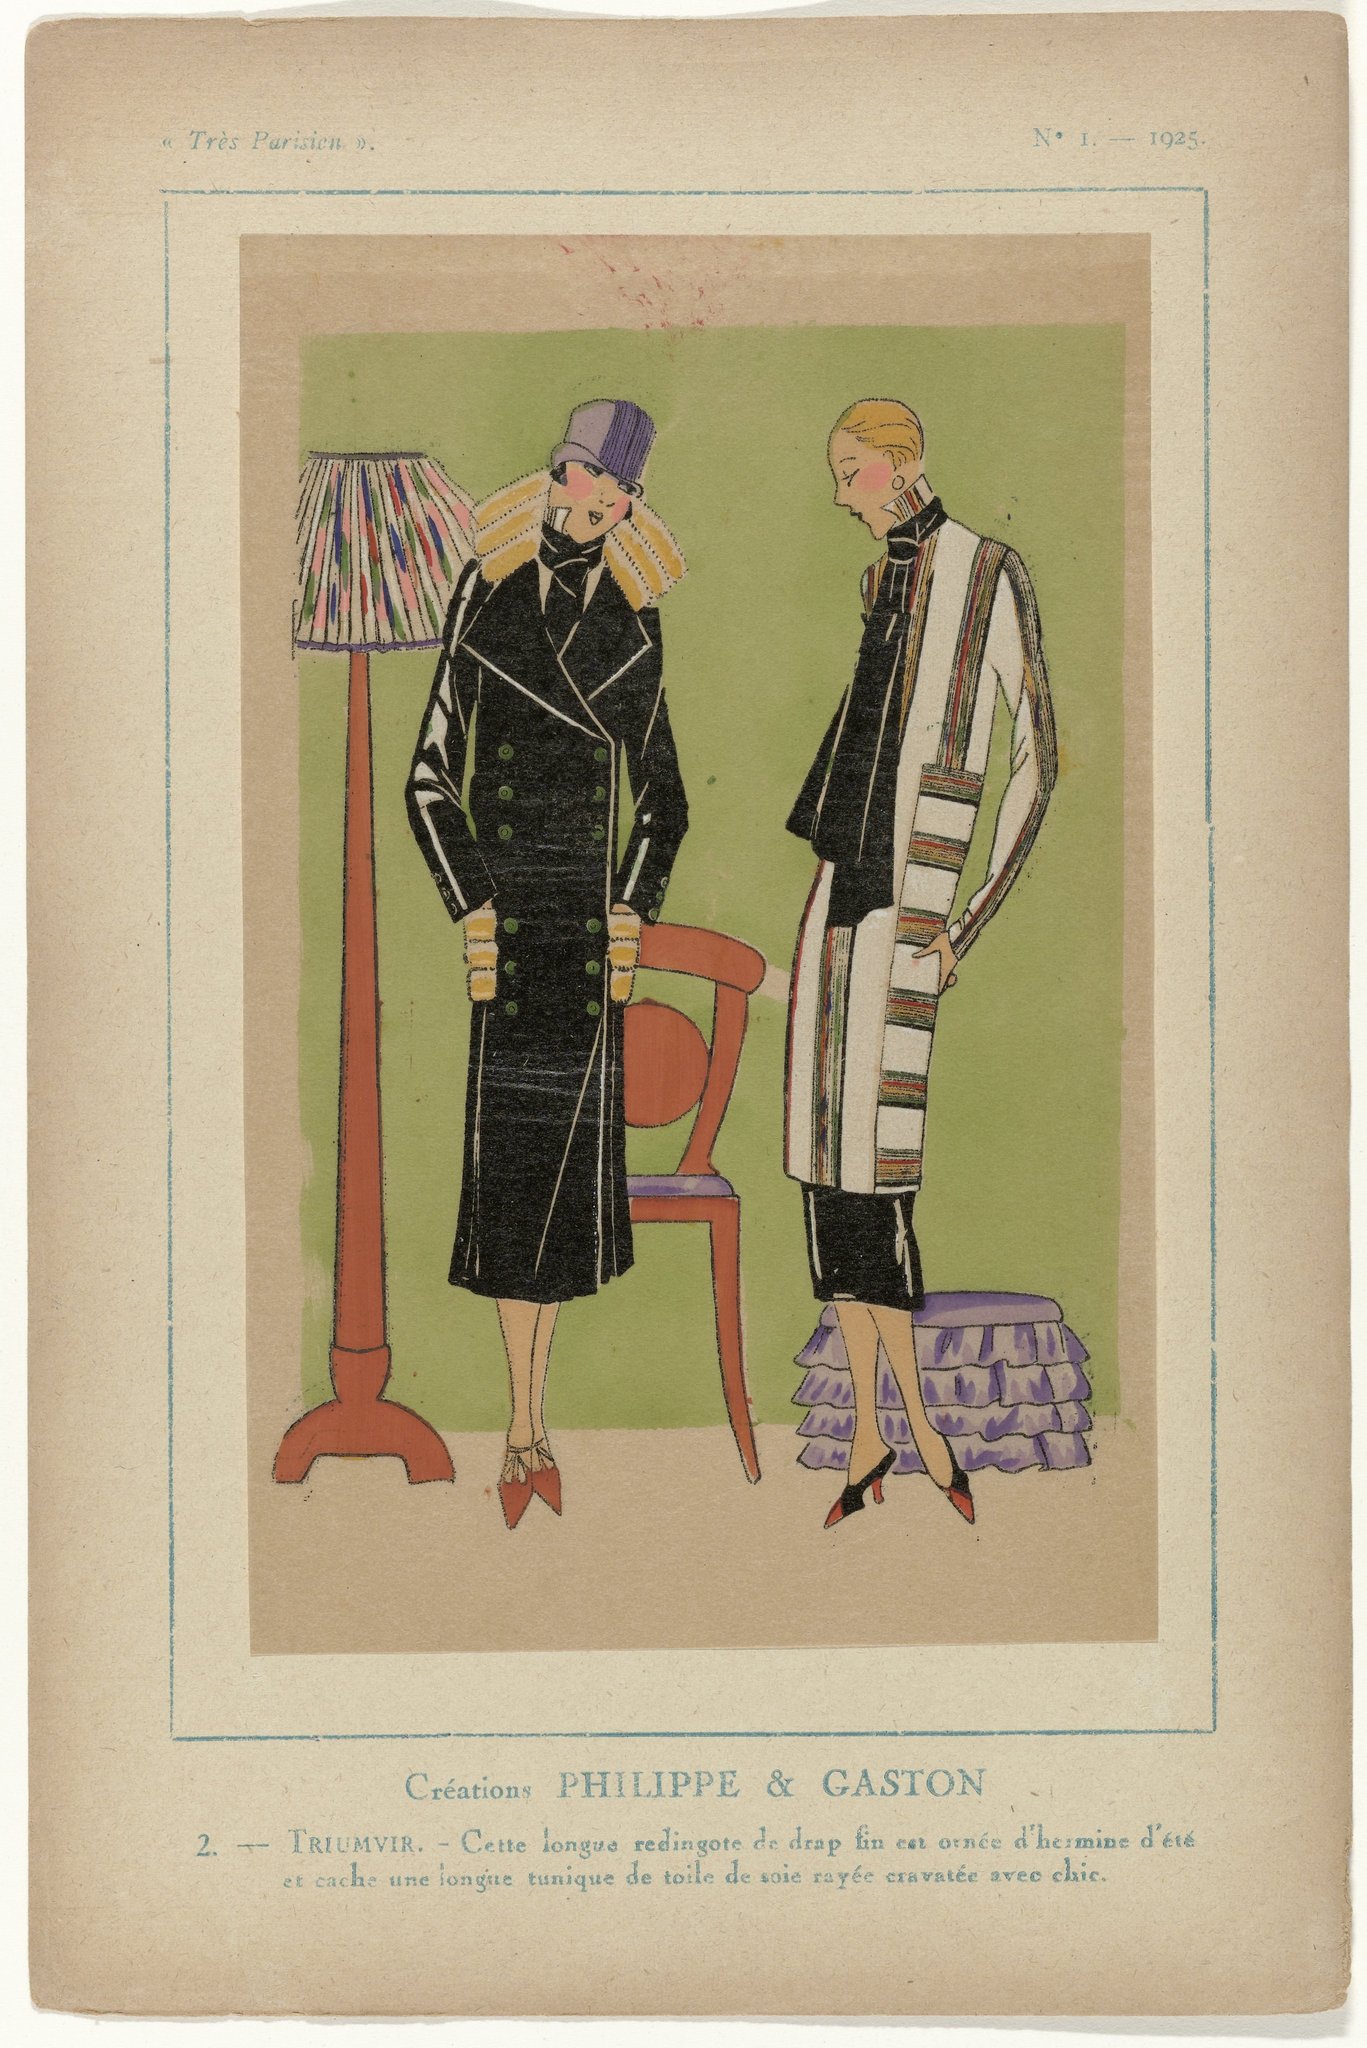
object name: fashion print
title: Très Parisien, 1925, No. 1, Pl. 2.- : CREATIONS PHILIPPE & GASTON - TRIUMVIR.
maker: g-p. joumard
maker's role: publisher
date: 1925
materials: paper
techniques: hand coloring, letterpress printing, lithography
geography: paris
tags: coat (+ women's clothes), dress, gown (tunique) (+ women's clothes), fashion plates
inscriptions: caption: ‘Cette longue redingote de drap fin est ornée d'hermine d'été et cache une longue tunique de toile de soie rayée cravatée avec chique’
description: Twee modellen van Philippe en Gaston, links een lange redingote en rechts een lange tuniek van zijde, met cravat. Prent uit het modetijdschrift Très Parisien...La Mode, Le Chic, L'Élégance (1920-1936)